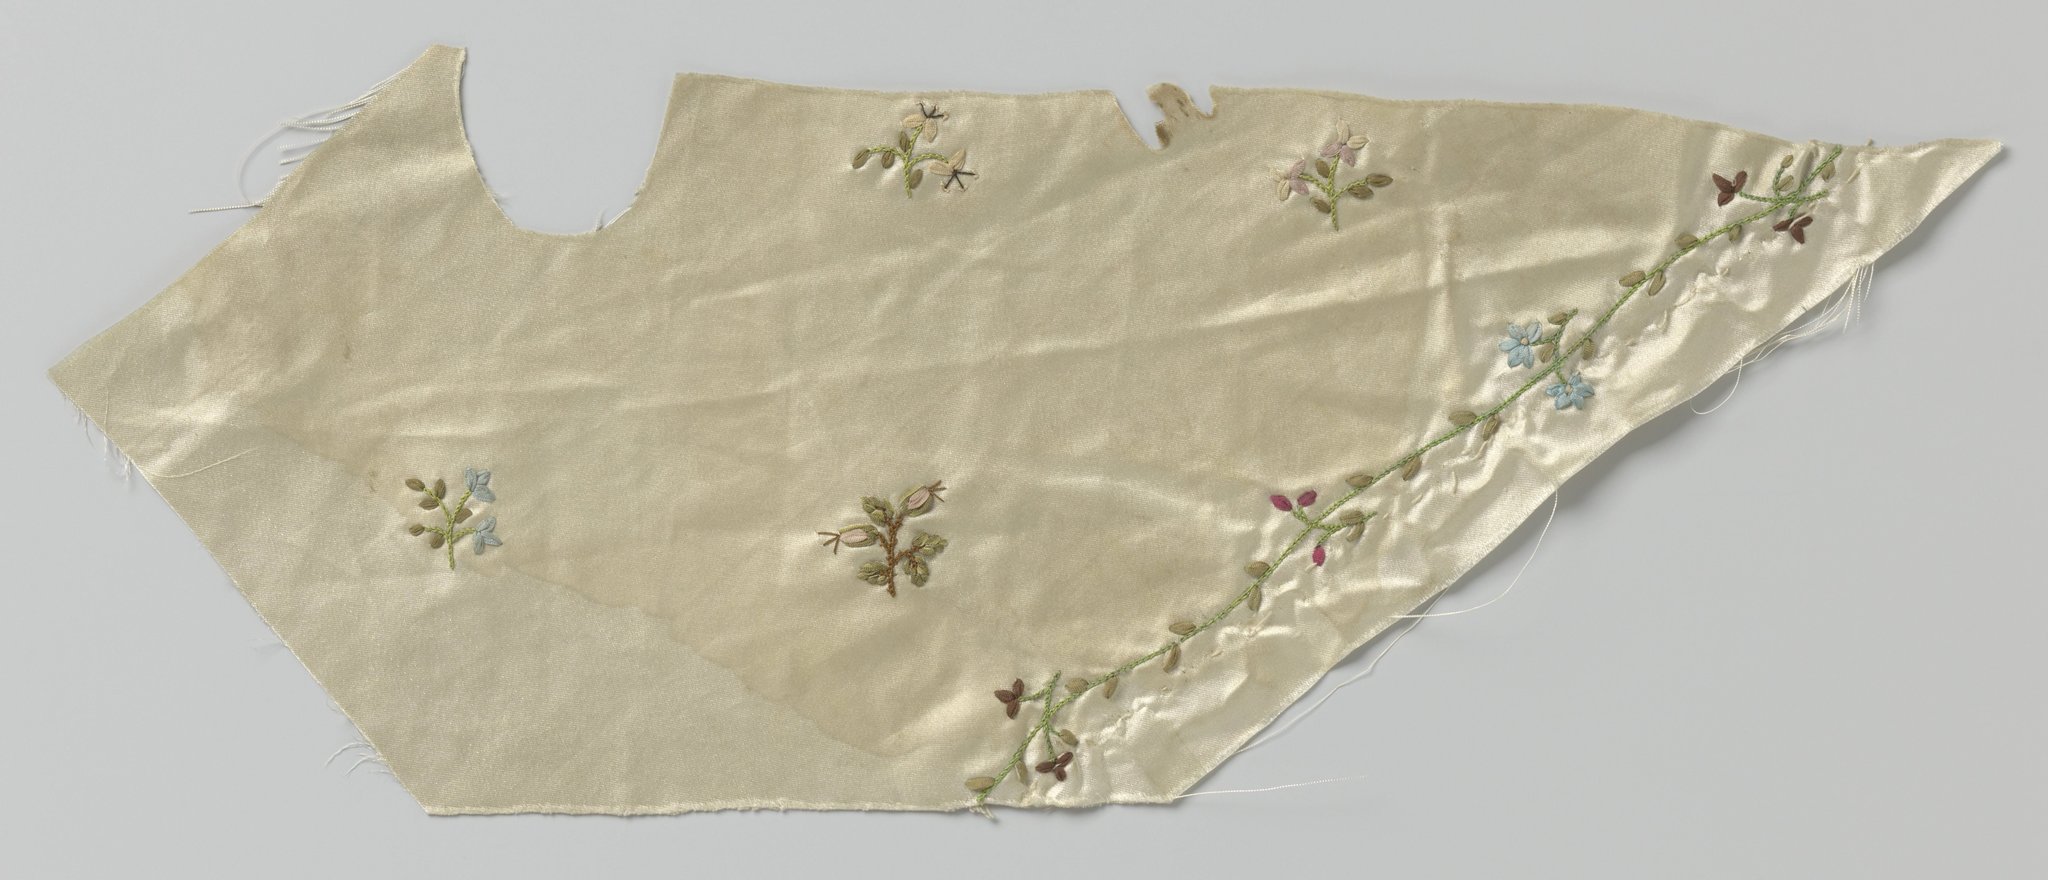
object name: embroidery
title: Fragment veelkleurig geborduurd weefsel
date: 1700-1750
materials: silk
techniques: embroidered, weave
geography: germany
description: Fragment wit zijdeweefsel met een geborduurd patroon van kleine, veelkleurige bloemen.